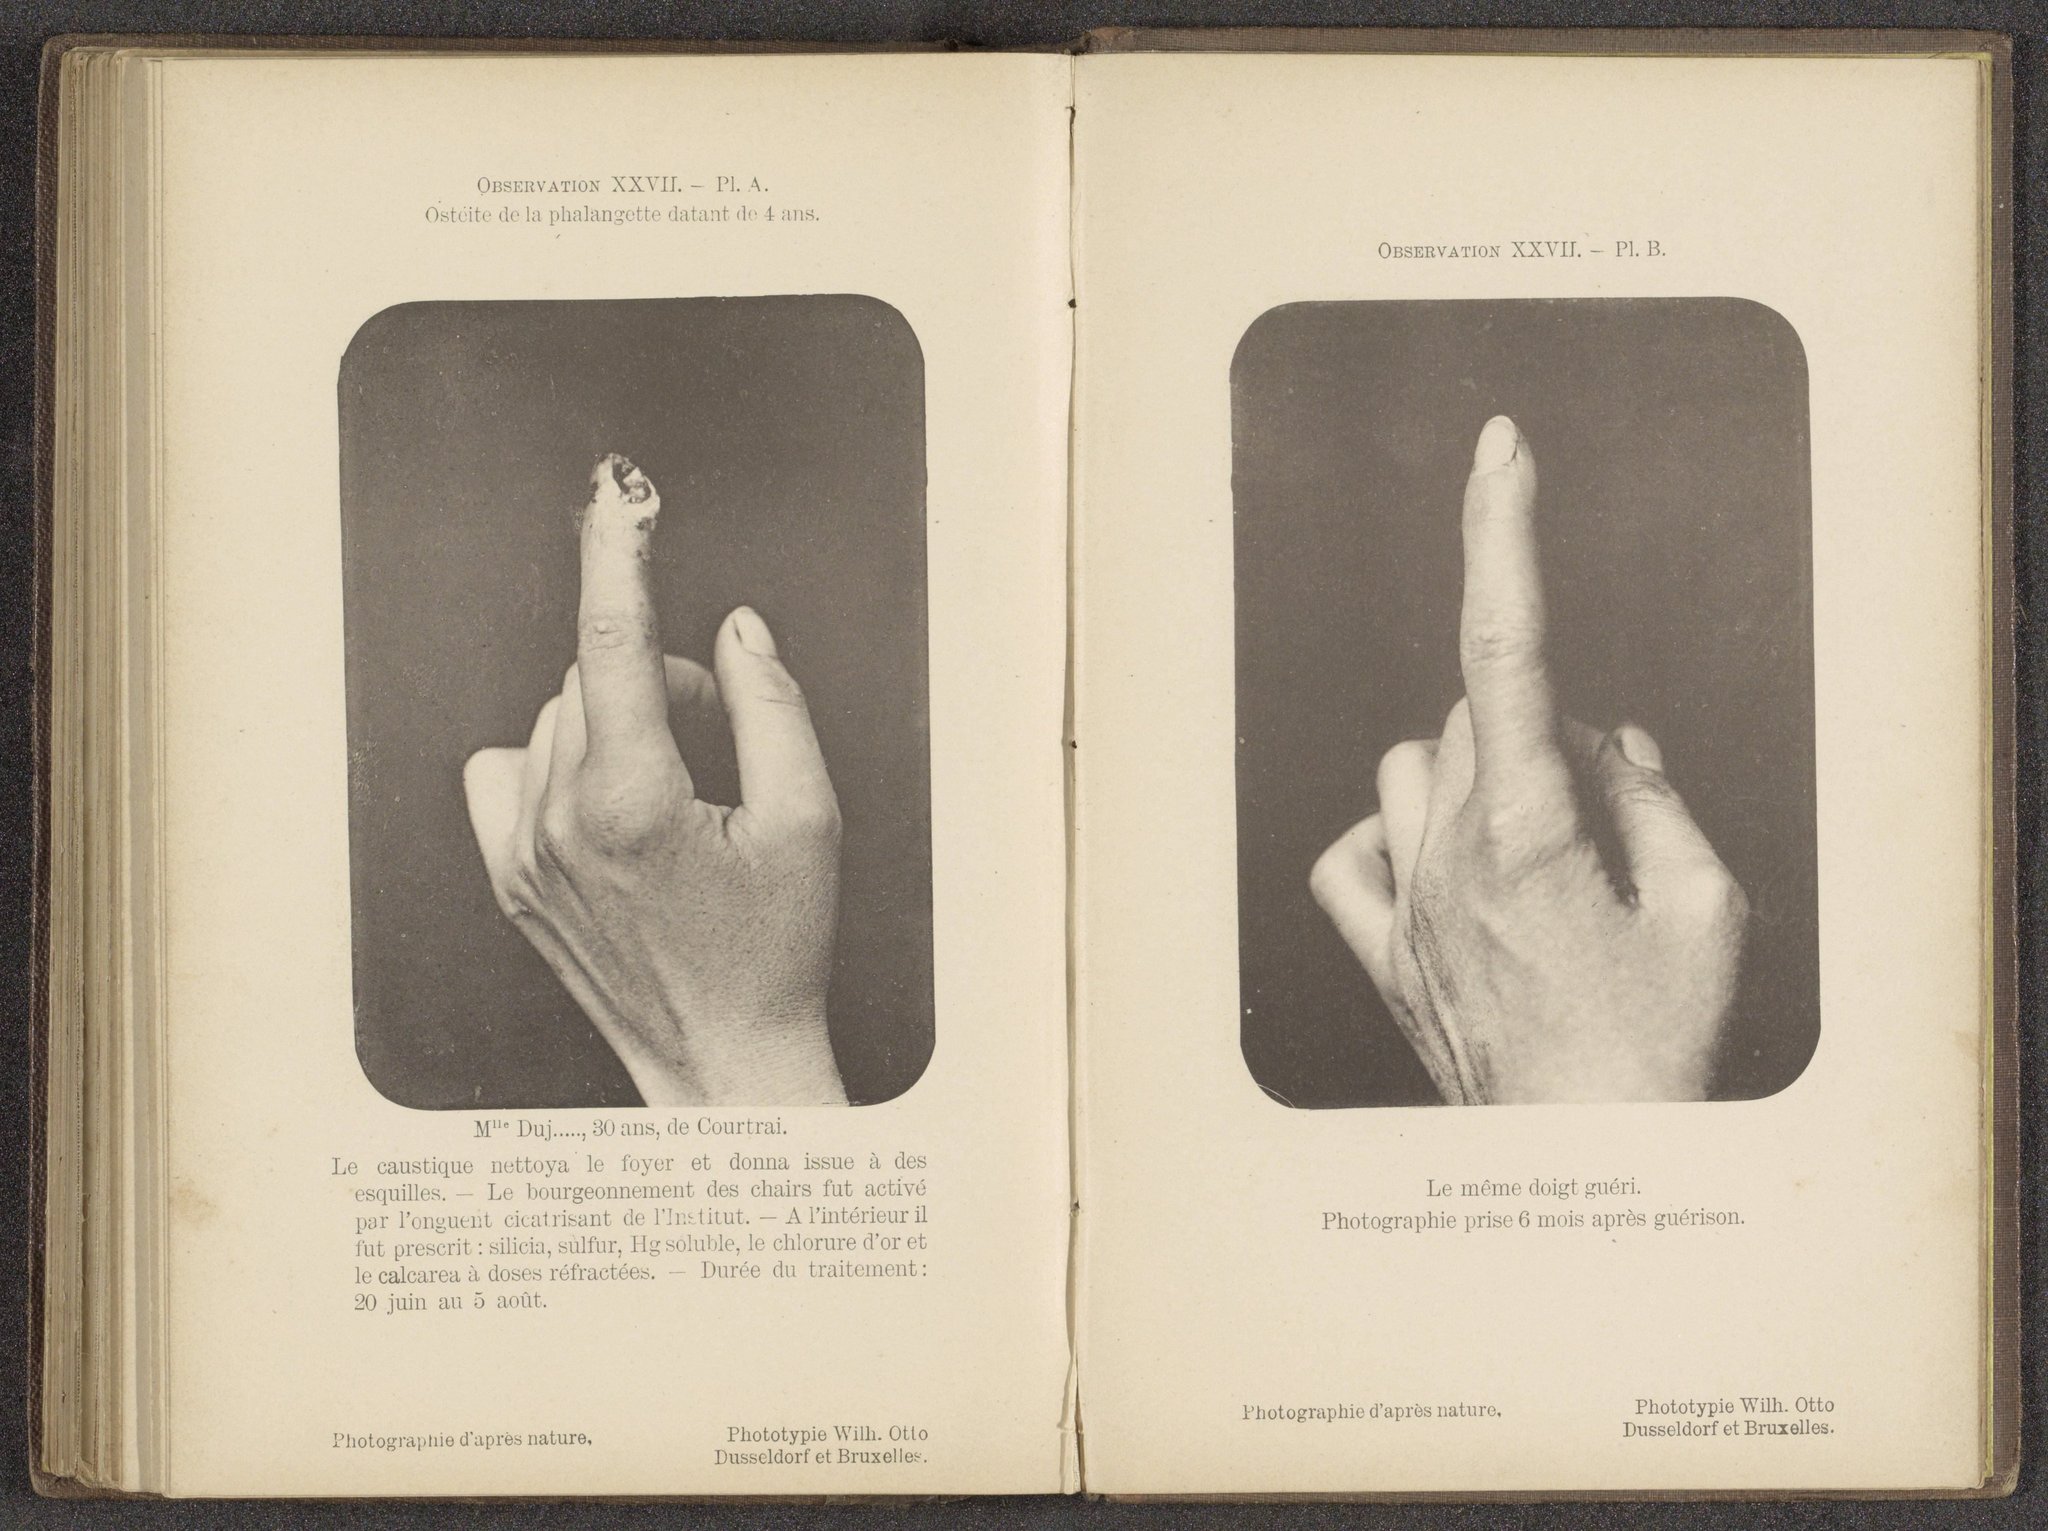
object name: page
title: Vinger met een geïnfecteerde wond (osteomyelitis)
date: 1874-1884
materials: paper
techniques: photograph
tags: infections and wounds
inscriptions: inscription: ‘Observation XXVII.. Pl. A. / Osteite de la phalangette datant de 4 ans. / Mlle Duj...., 30 ans, de Courtrai. (...)’